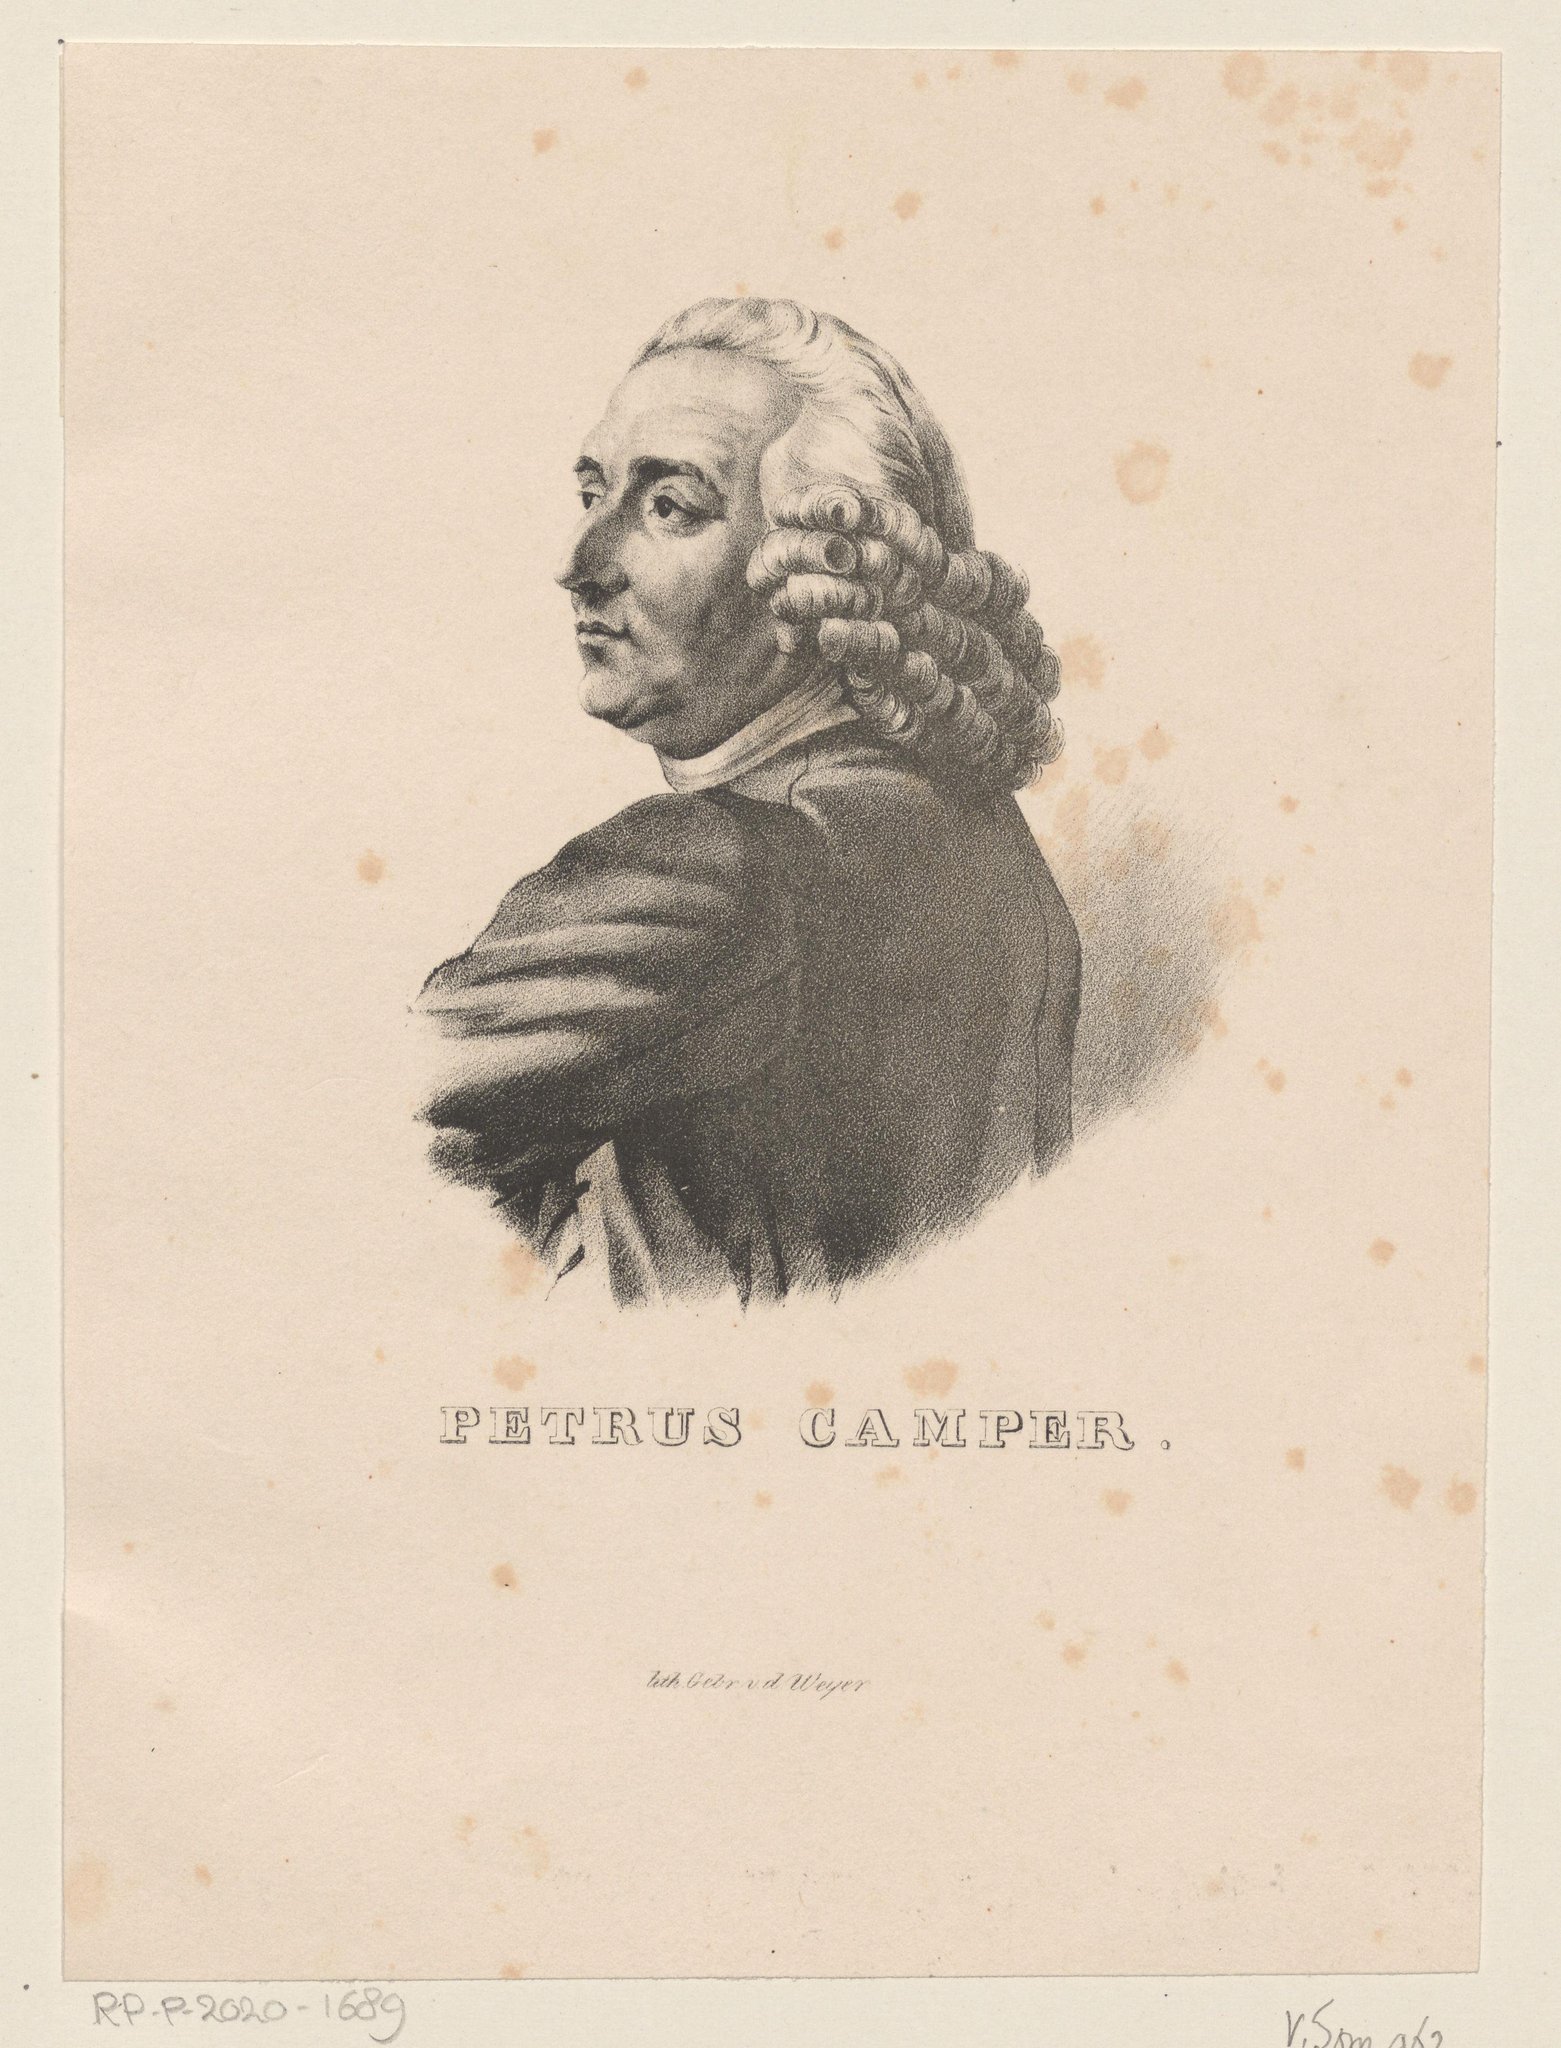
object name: print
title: Portret van Petrus Camper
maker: Anonymous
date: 1834-1840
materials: paper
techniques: lithograph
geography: utrecht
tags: print maker, draughtsman, petrus camper, historical persons